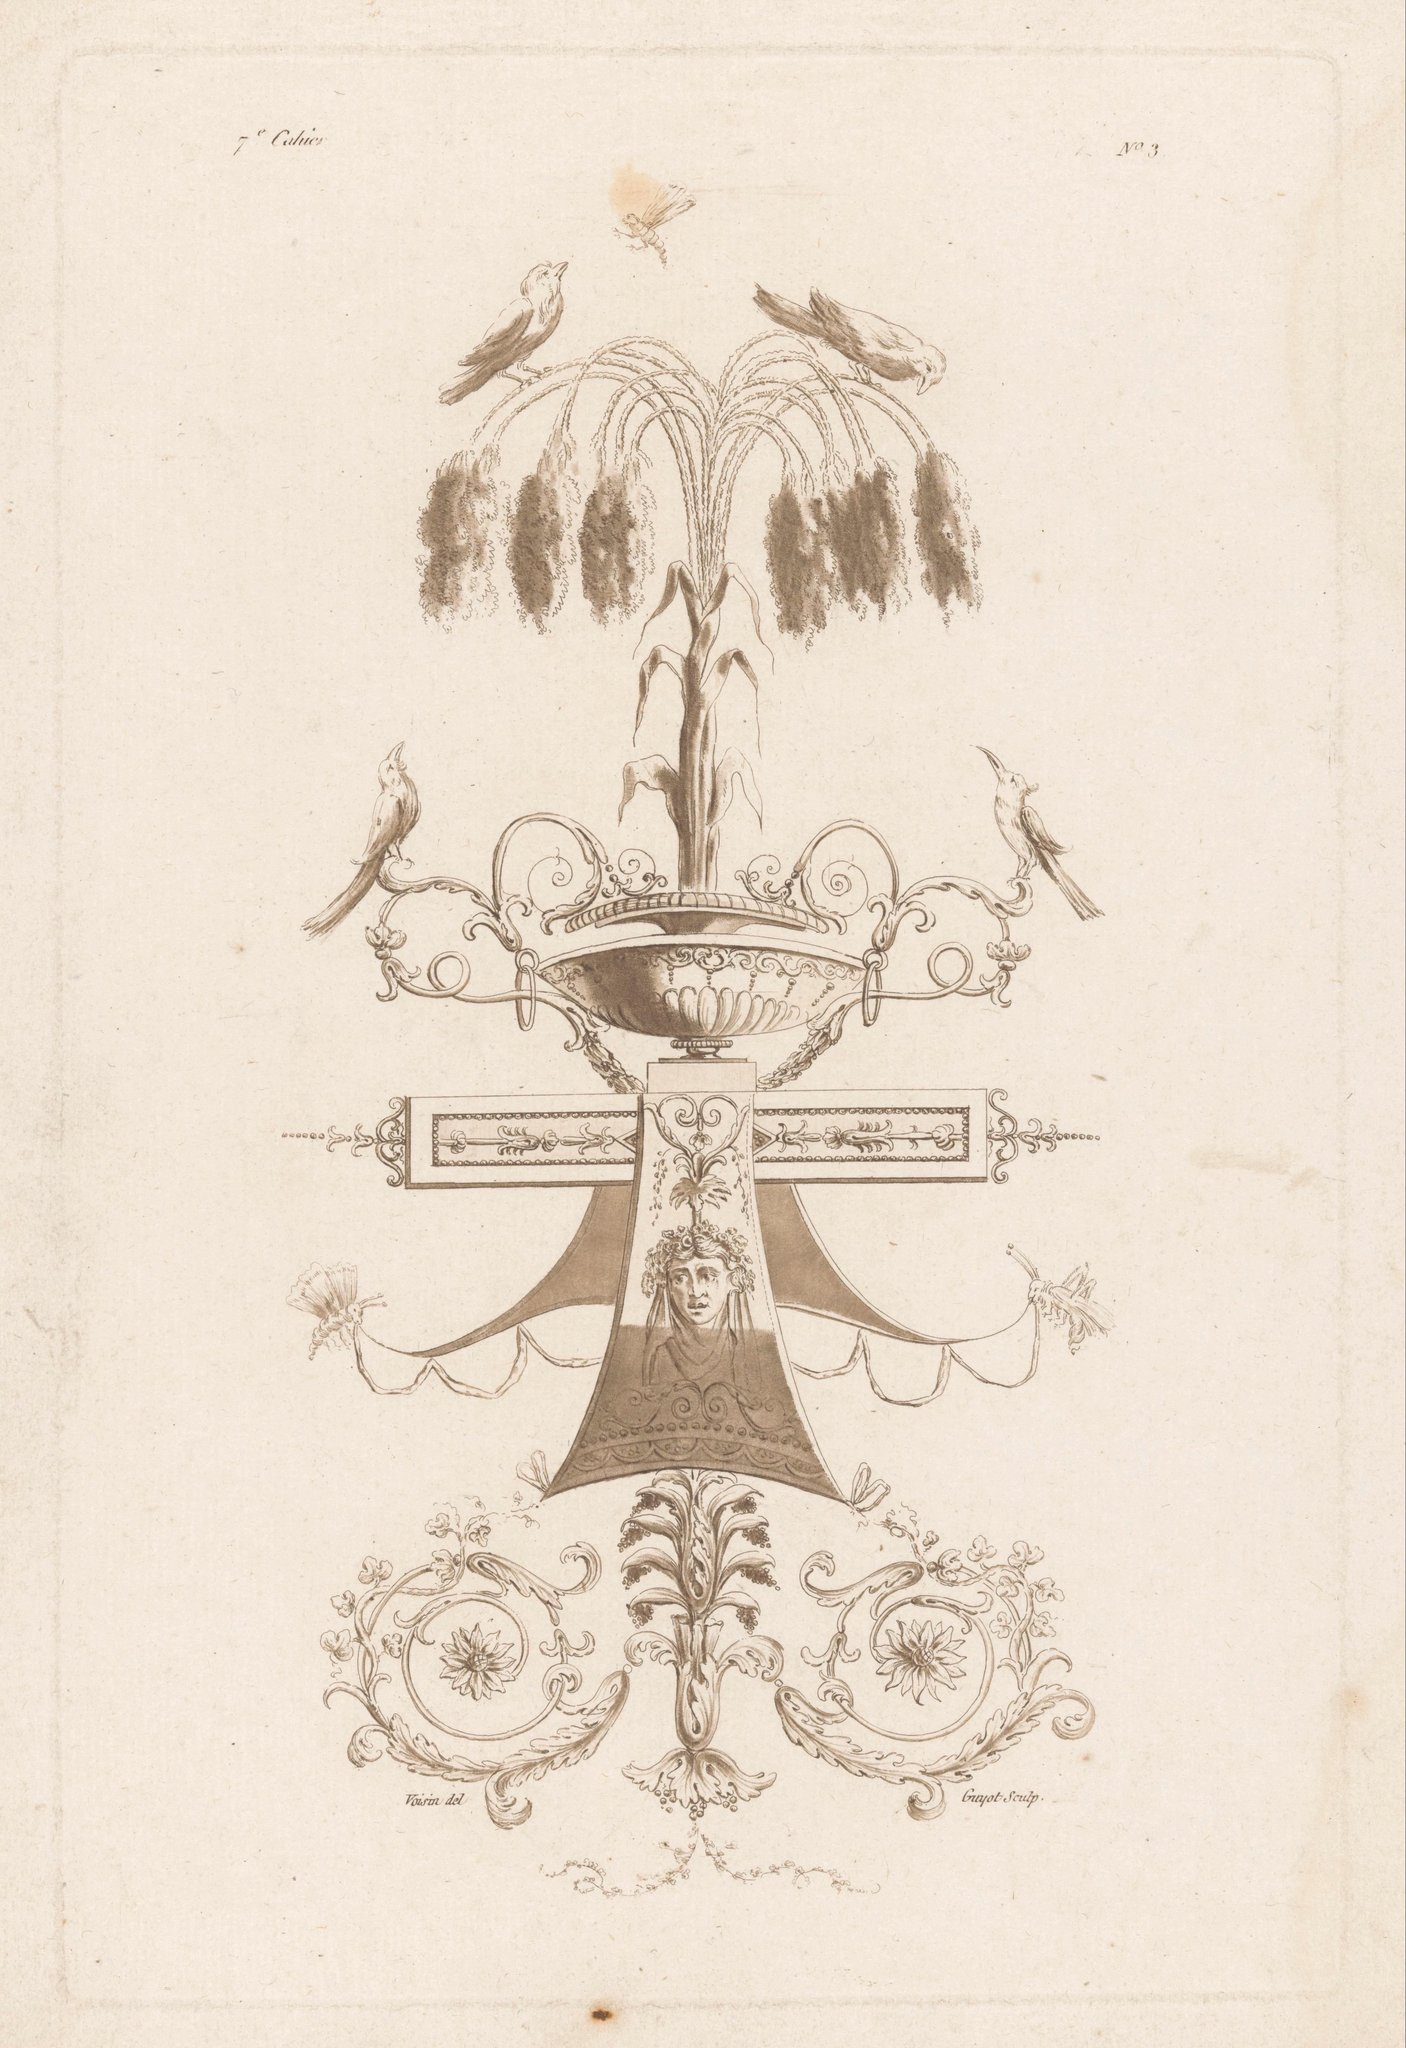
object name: print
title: Arabesken met vogels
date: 1788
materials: paper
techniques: aquatint, etching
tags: ornament ~ arabesque, birds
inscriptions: collector's mark: Lugt 2228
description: Een vaas met aren en arabesken waarop vogels zitten. Aan de onderzijde arabesken, insecten en een masker.